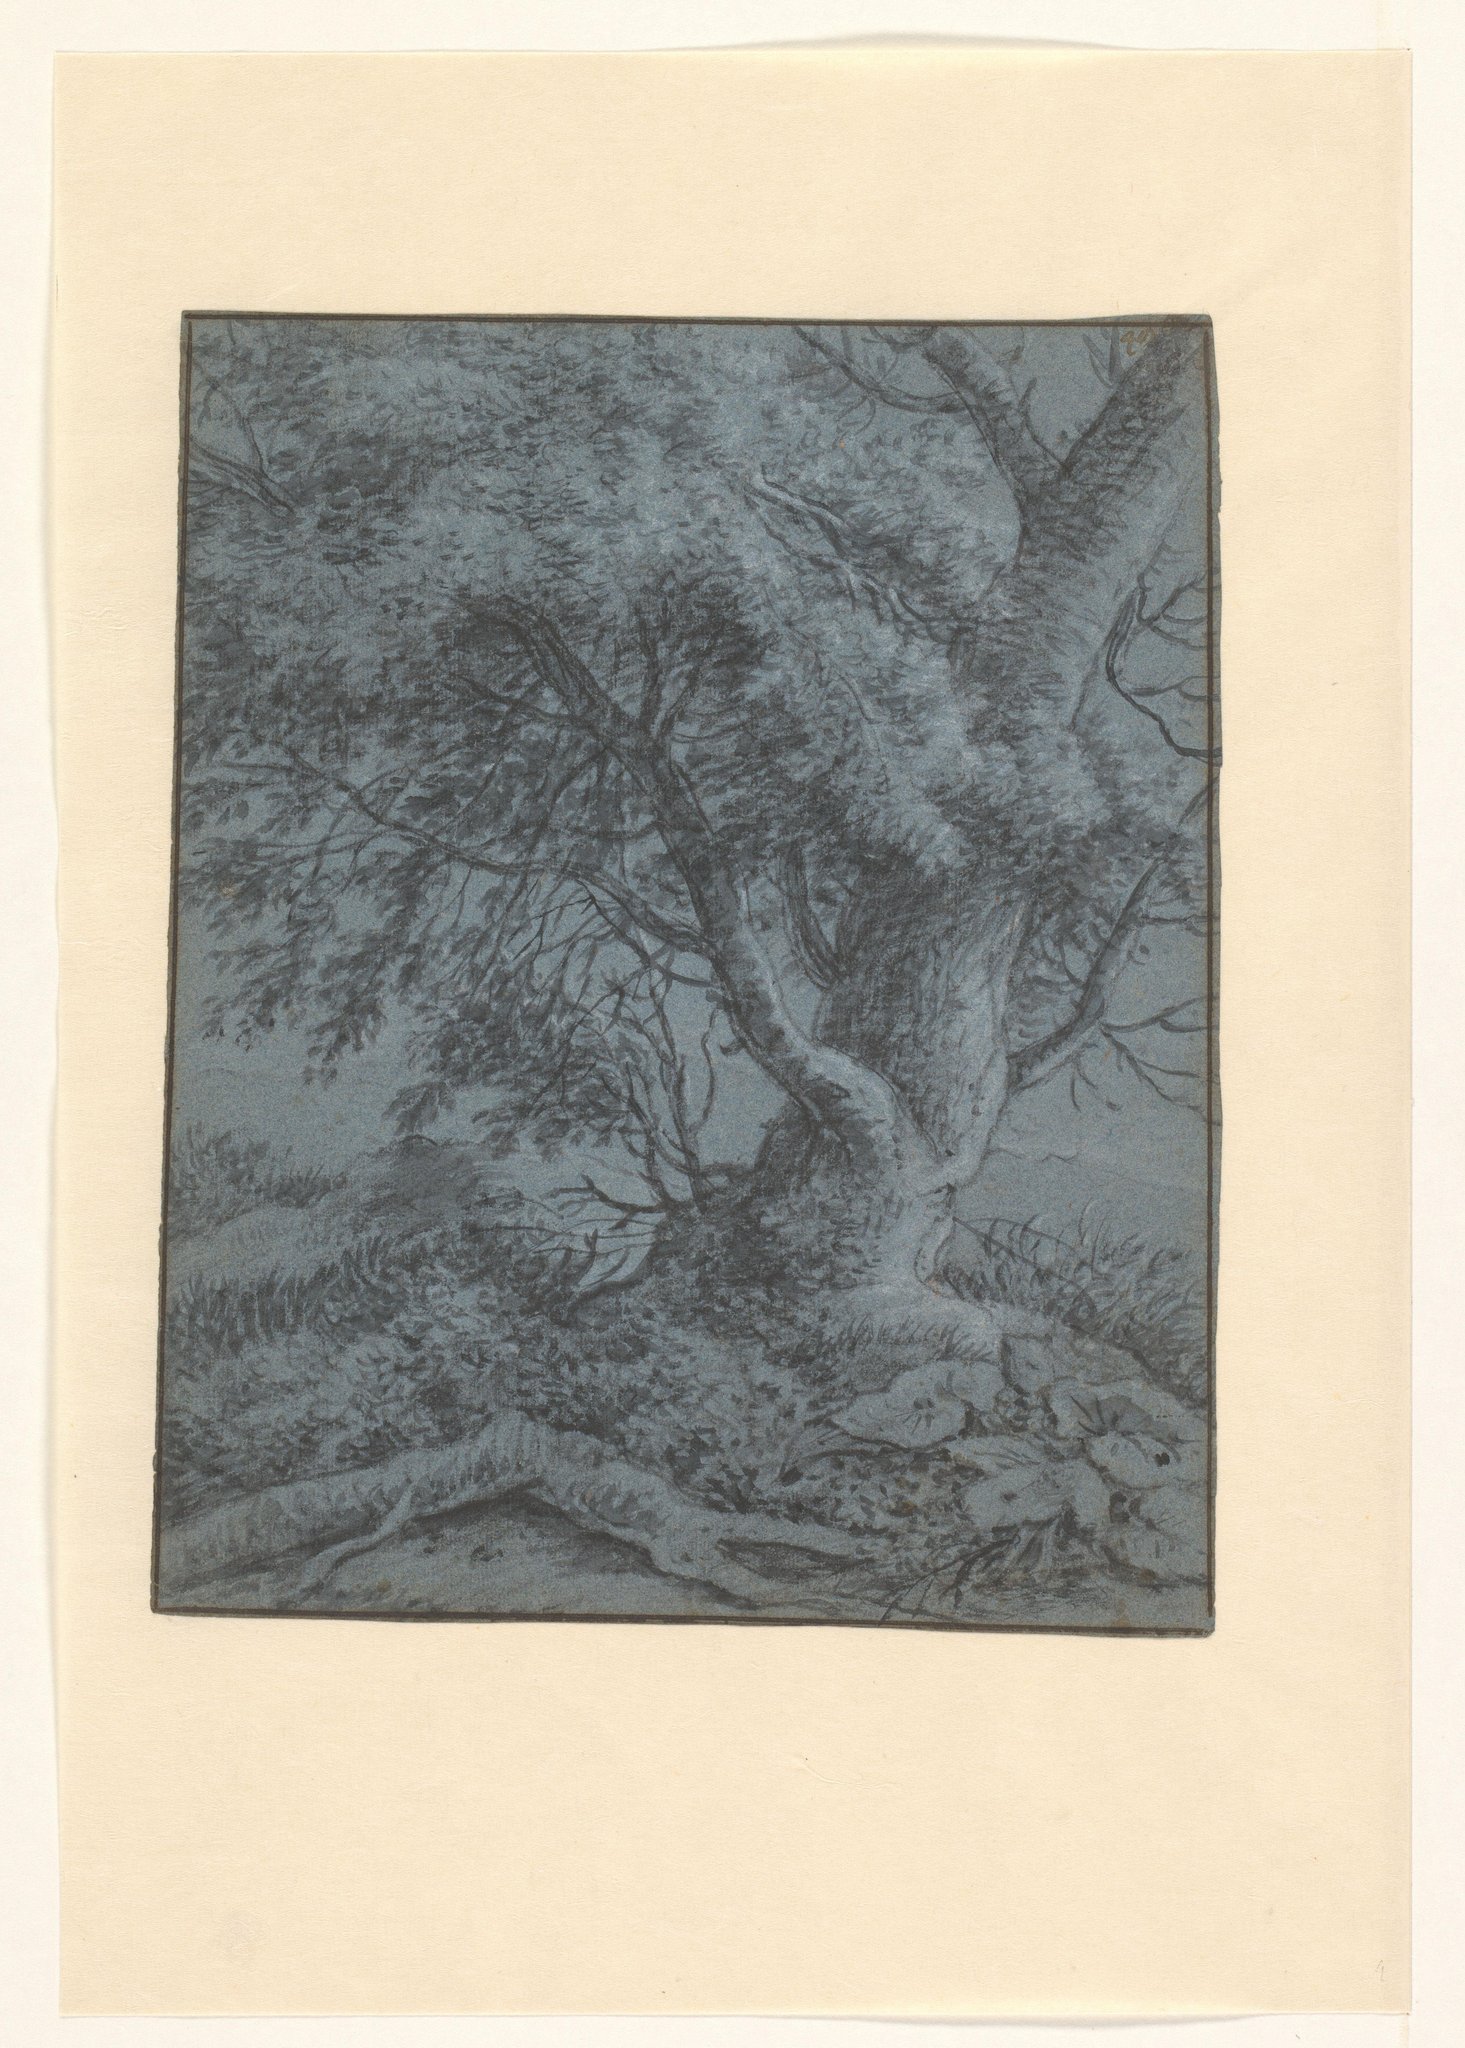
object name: drawing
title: Oude boom op een heuvelrand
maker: simon de vlieger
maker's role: draughtsman, painter, print maker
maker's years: 1600-1653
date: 1610-1653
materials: chalk, paper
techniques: brush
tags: trees, forest, wood